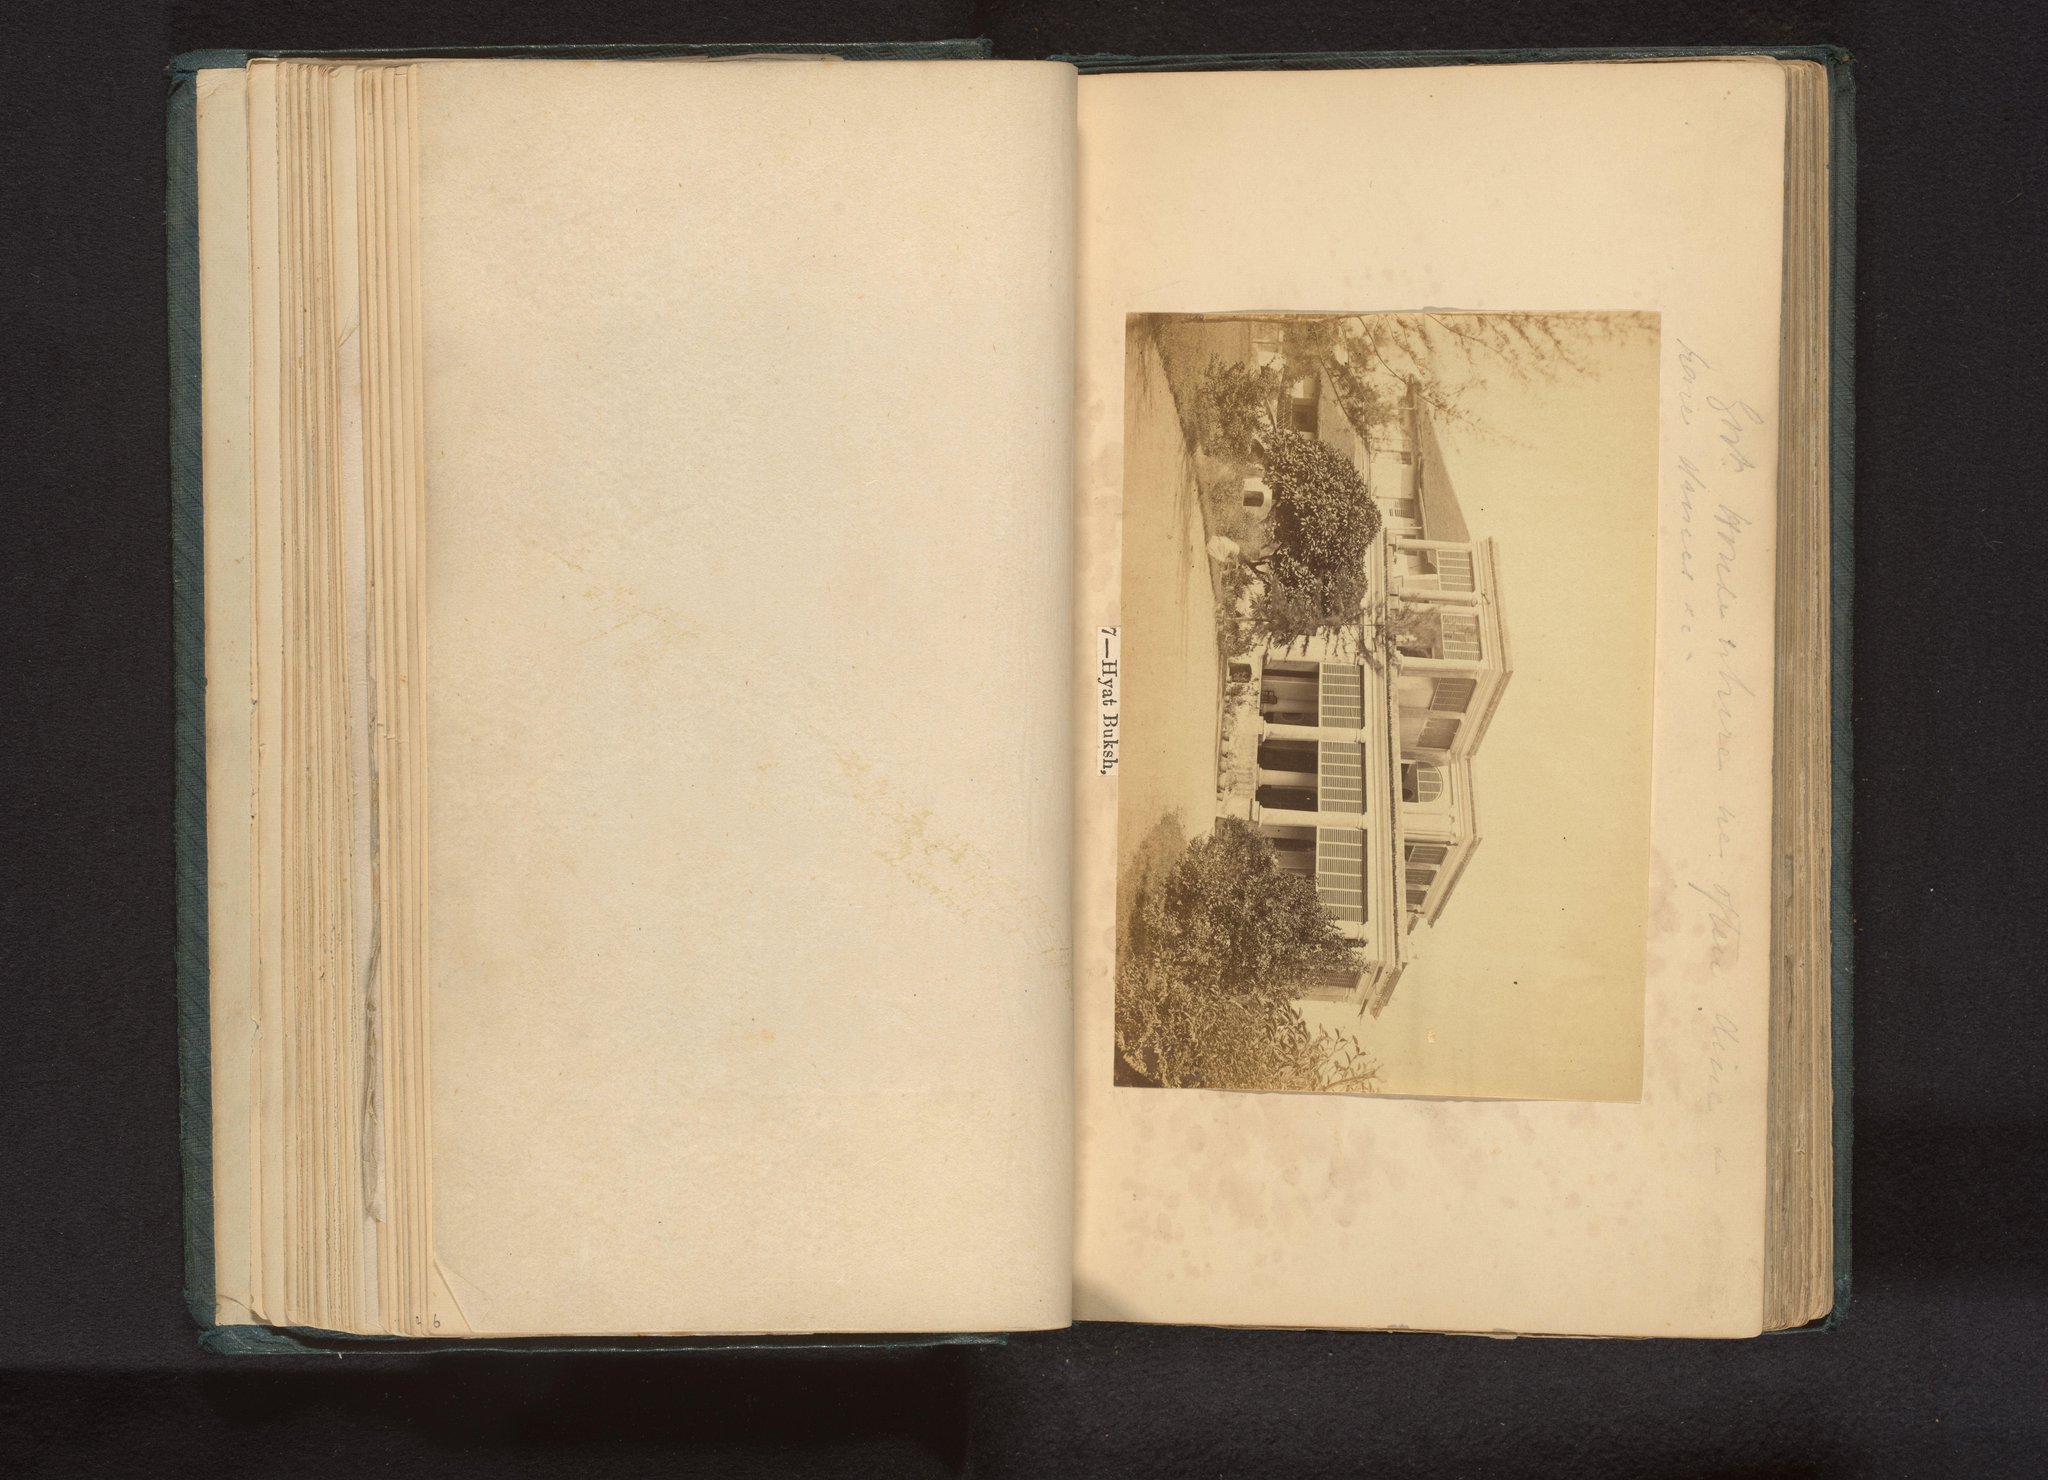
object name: page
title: Gezicht op een overheidsgebouw, Banks Kothi, in Lucknow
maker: darogha ubbas alli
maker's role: fotograaf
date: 1864-1874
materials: photographic support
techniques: albumen print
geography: lucknow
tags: housing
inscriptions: number: ‘7’, inscription: ‘[...] where we often dine + have dances’